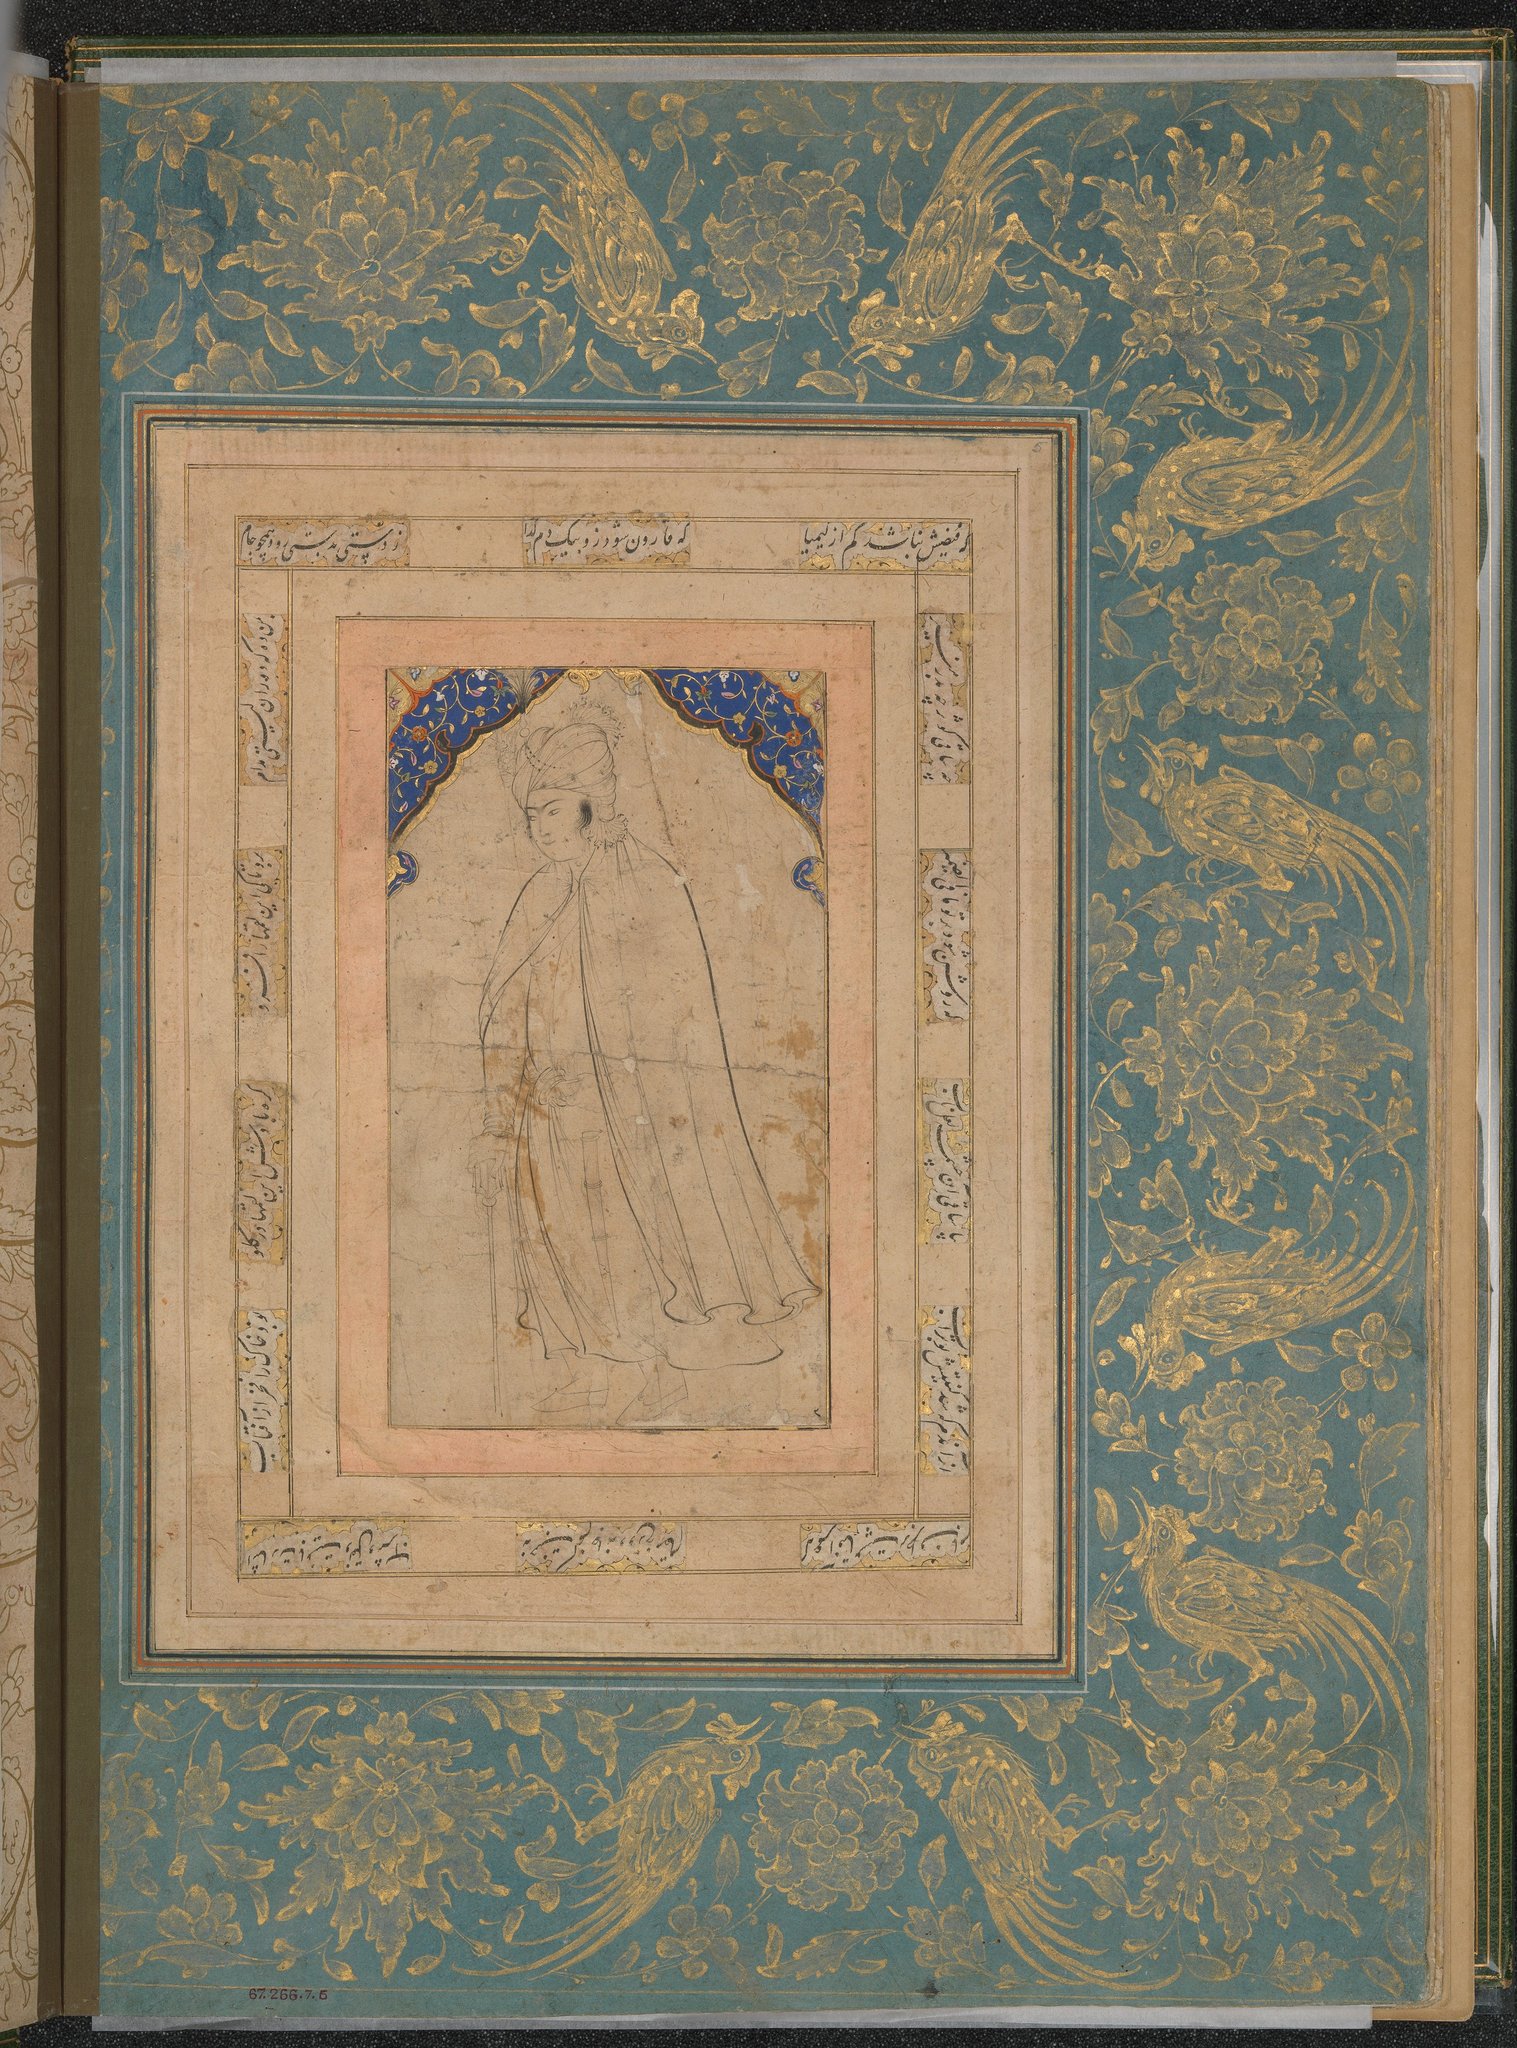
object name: album leaf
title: "Standing Youth in a Cape," Folio from the Bellini Album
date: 1567-1600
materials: gold, ink, paper, watercolor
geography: iran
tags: birds,men,portraits,flowers